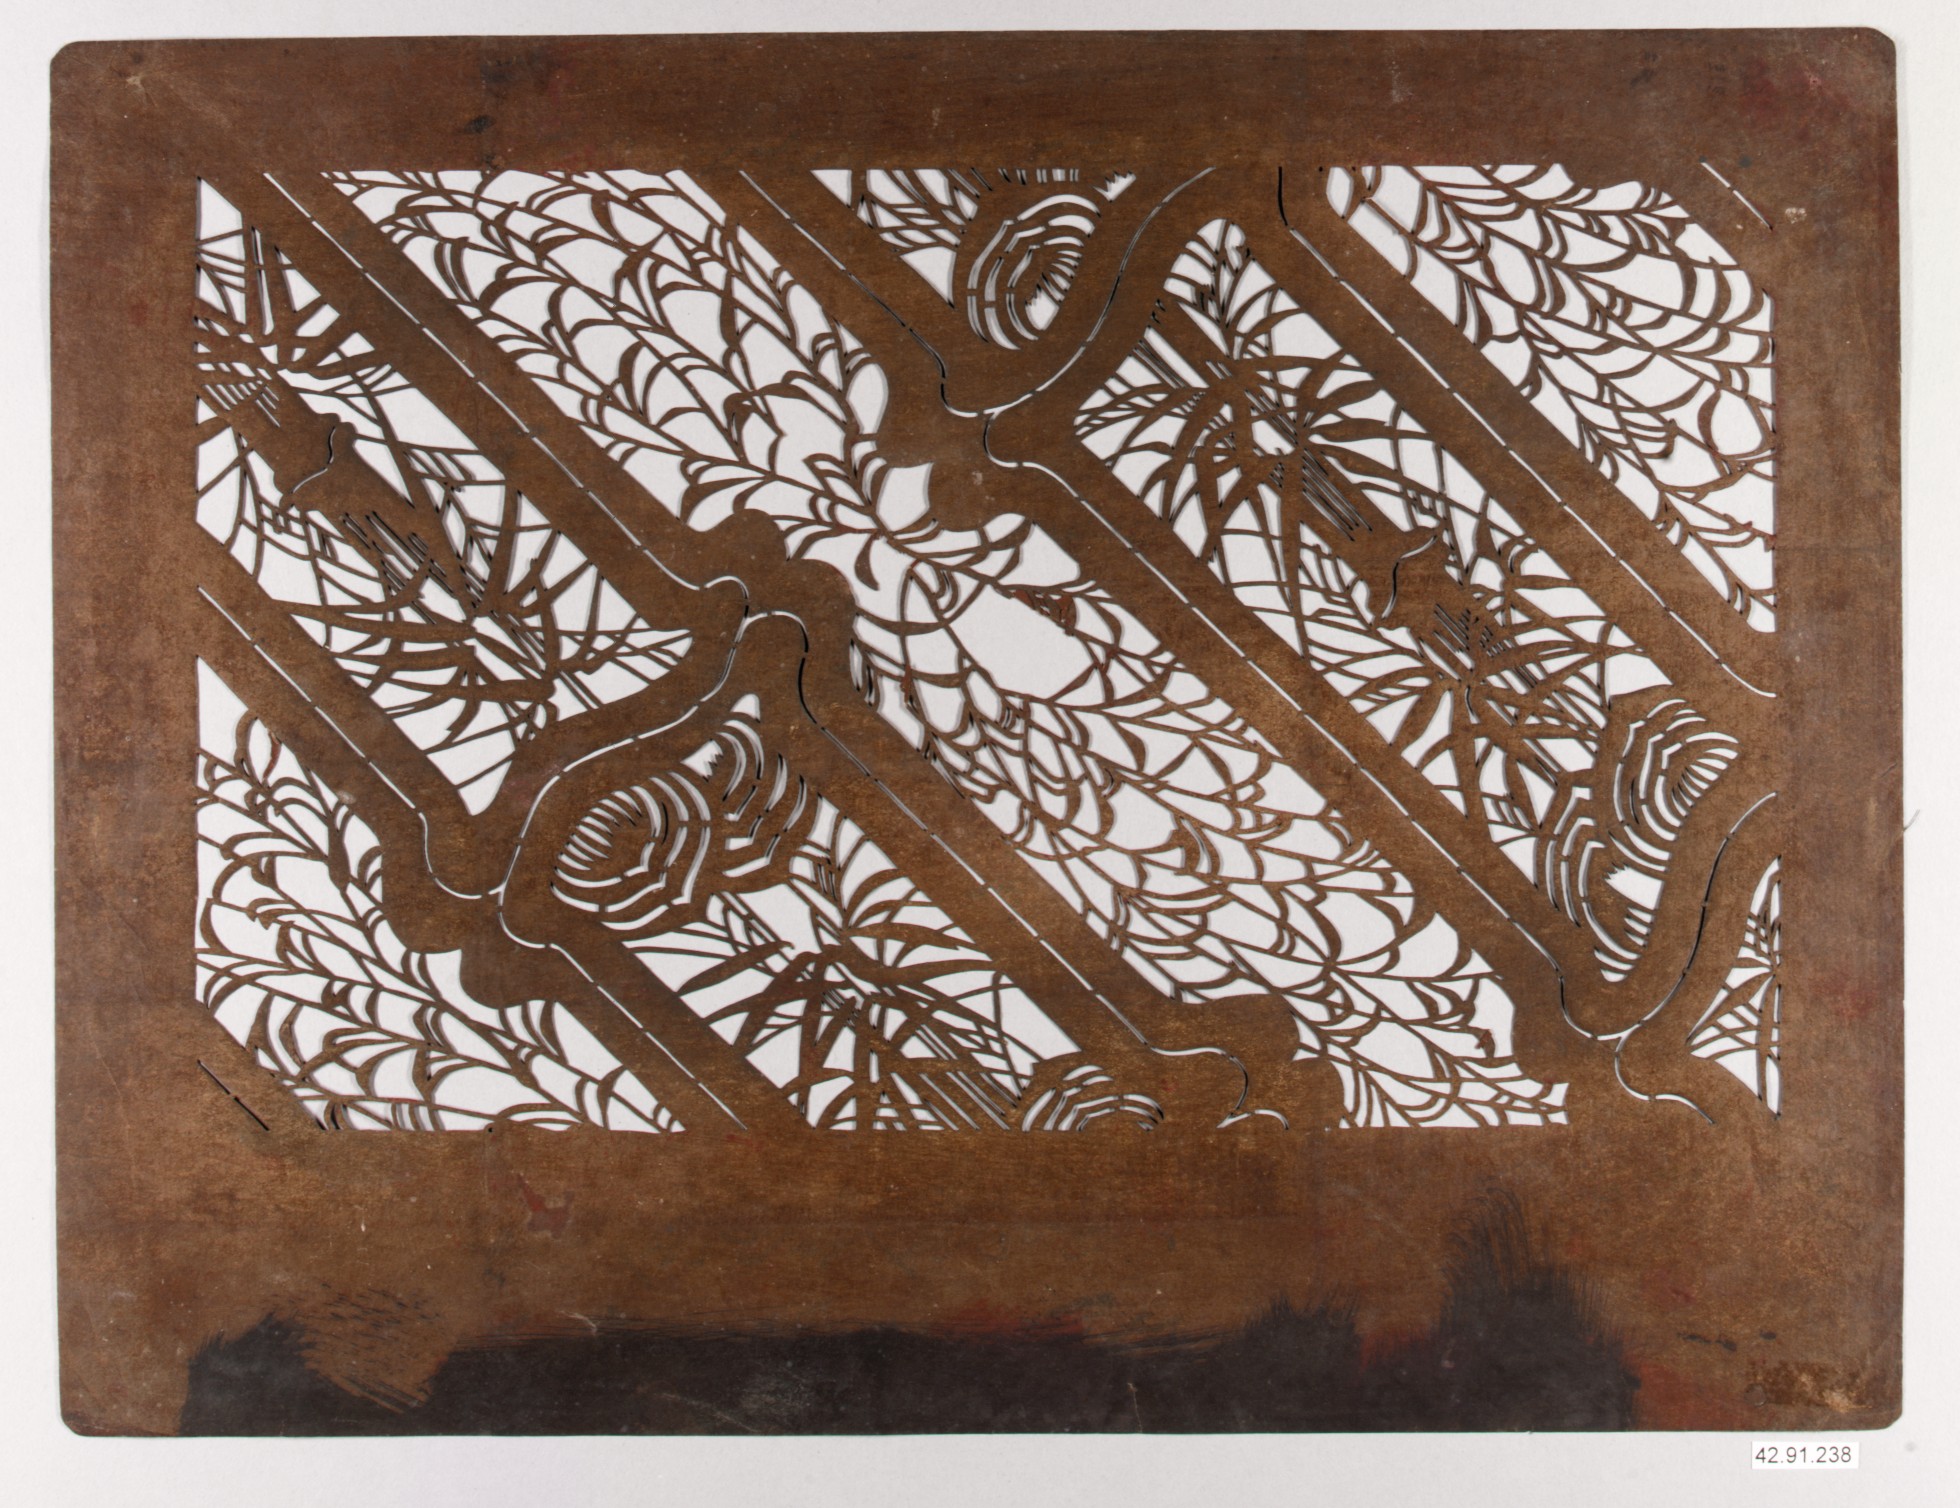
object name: stencil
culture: japanese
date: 1801-1900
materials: paper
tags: bamboo